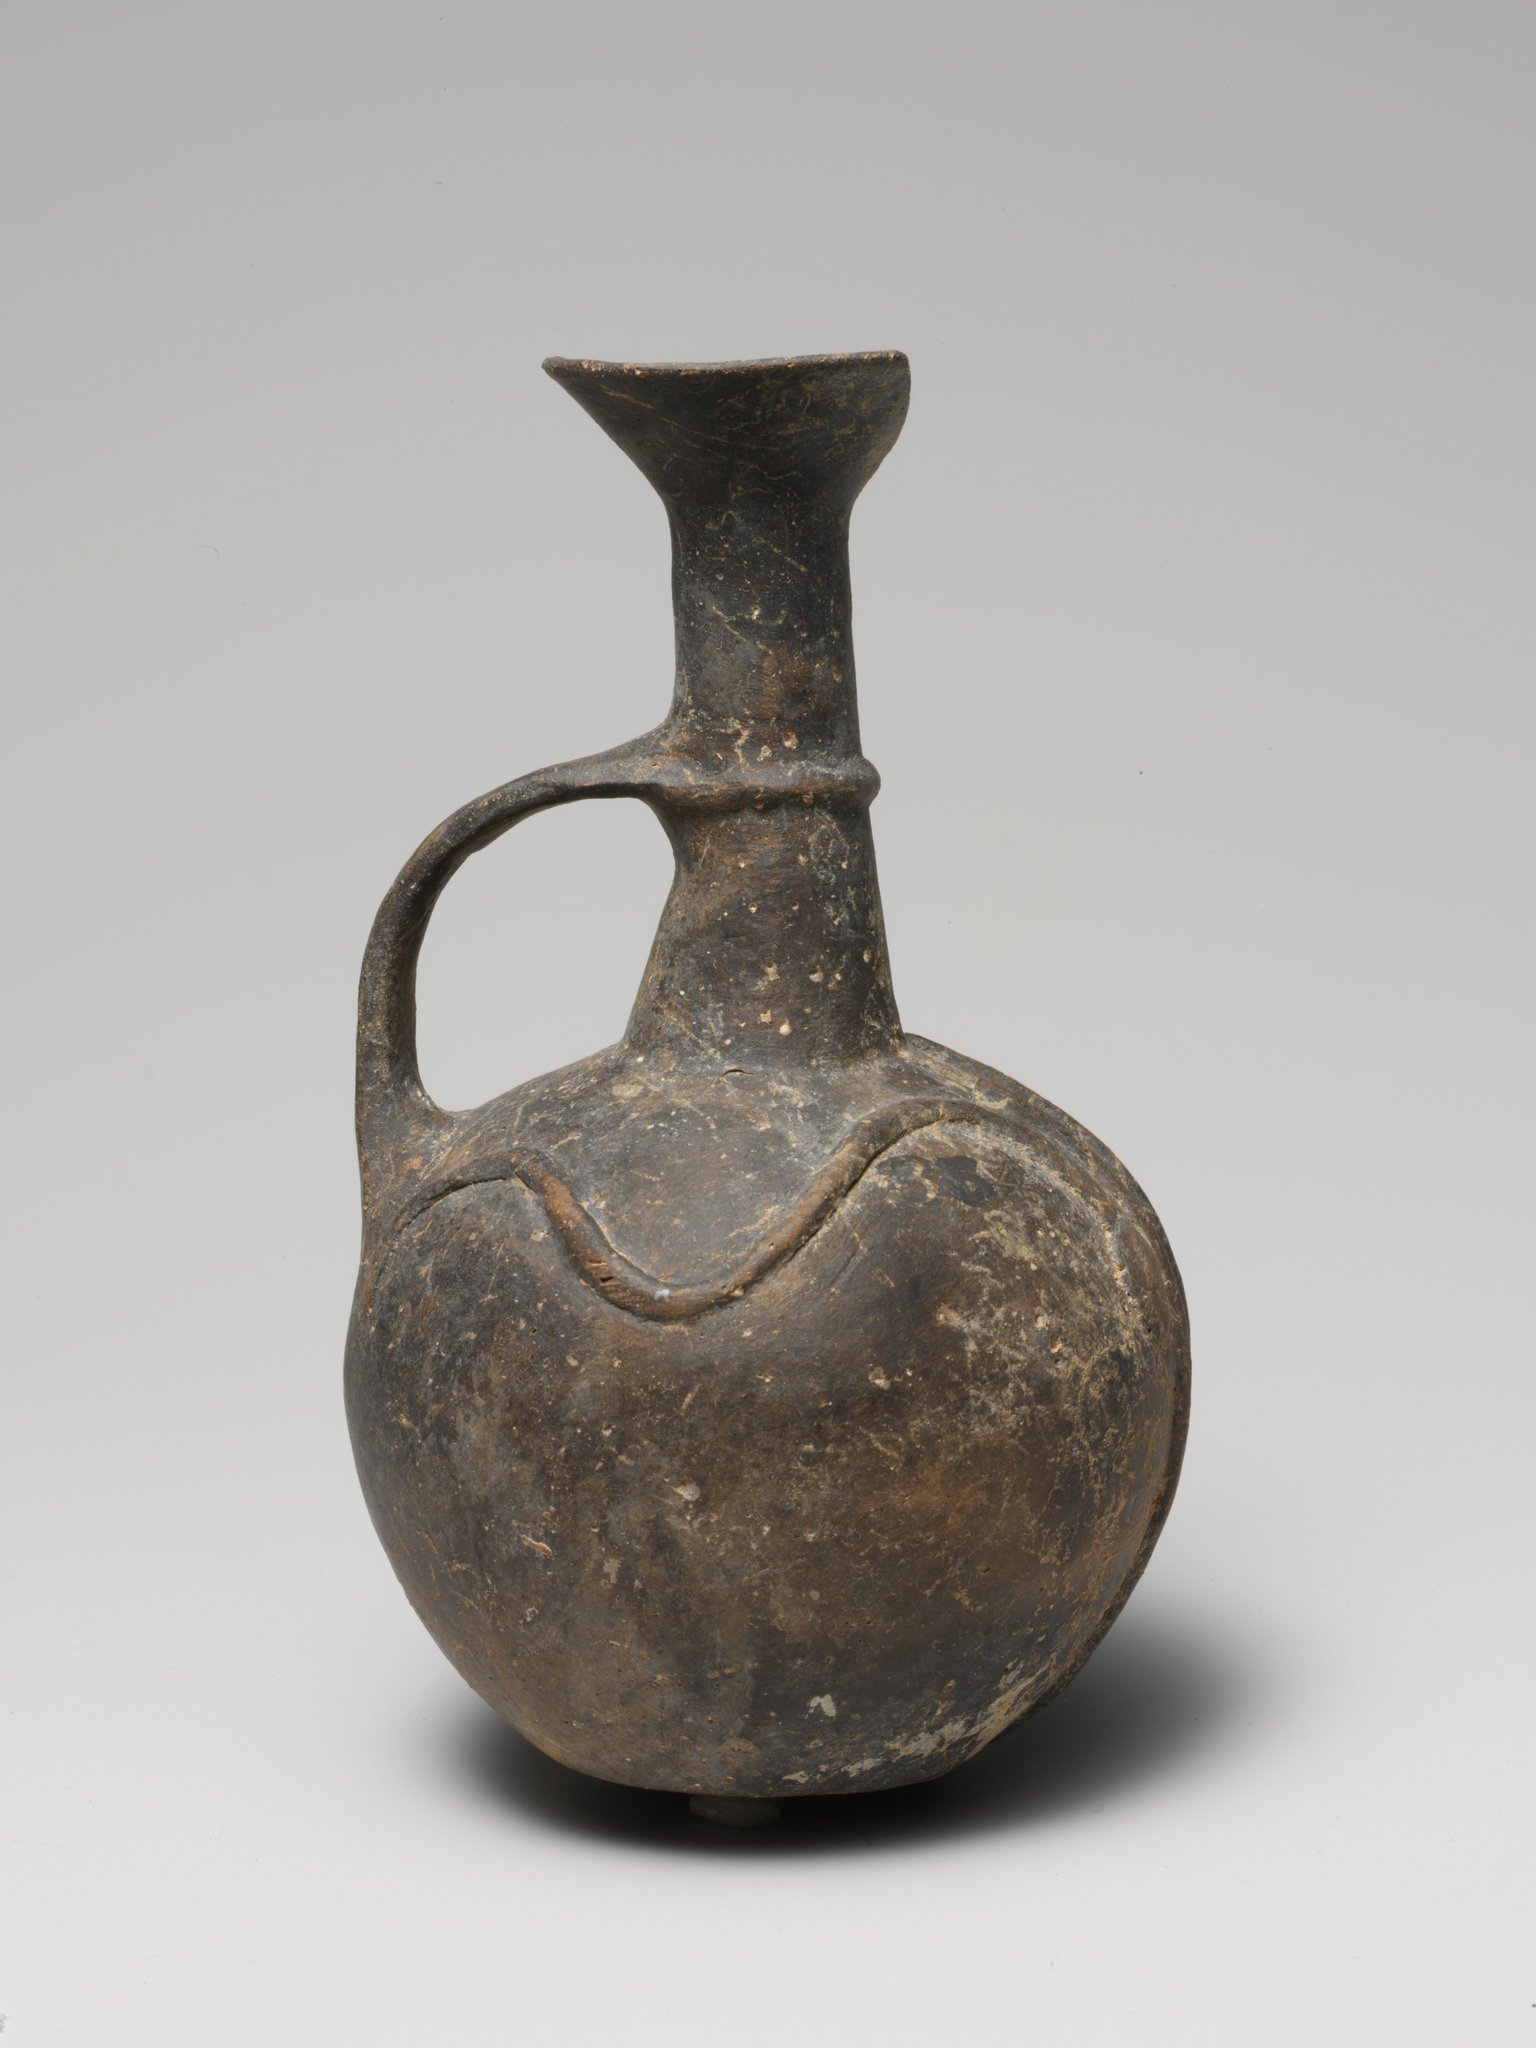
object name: juglet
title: Terracotta juglet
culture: cypriot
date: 1600-1450 BCE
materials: terracotta